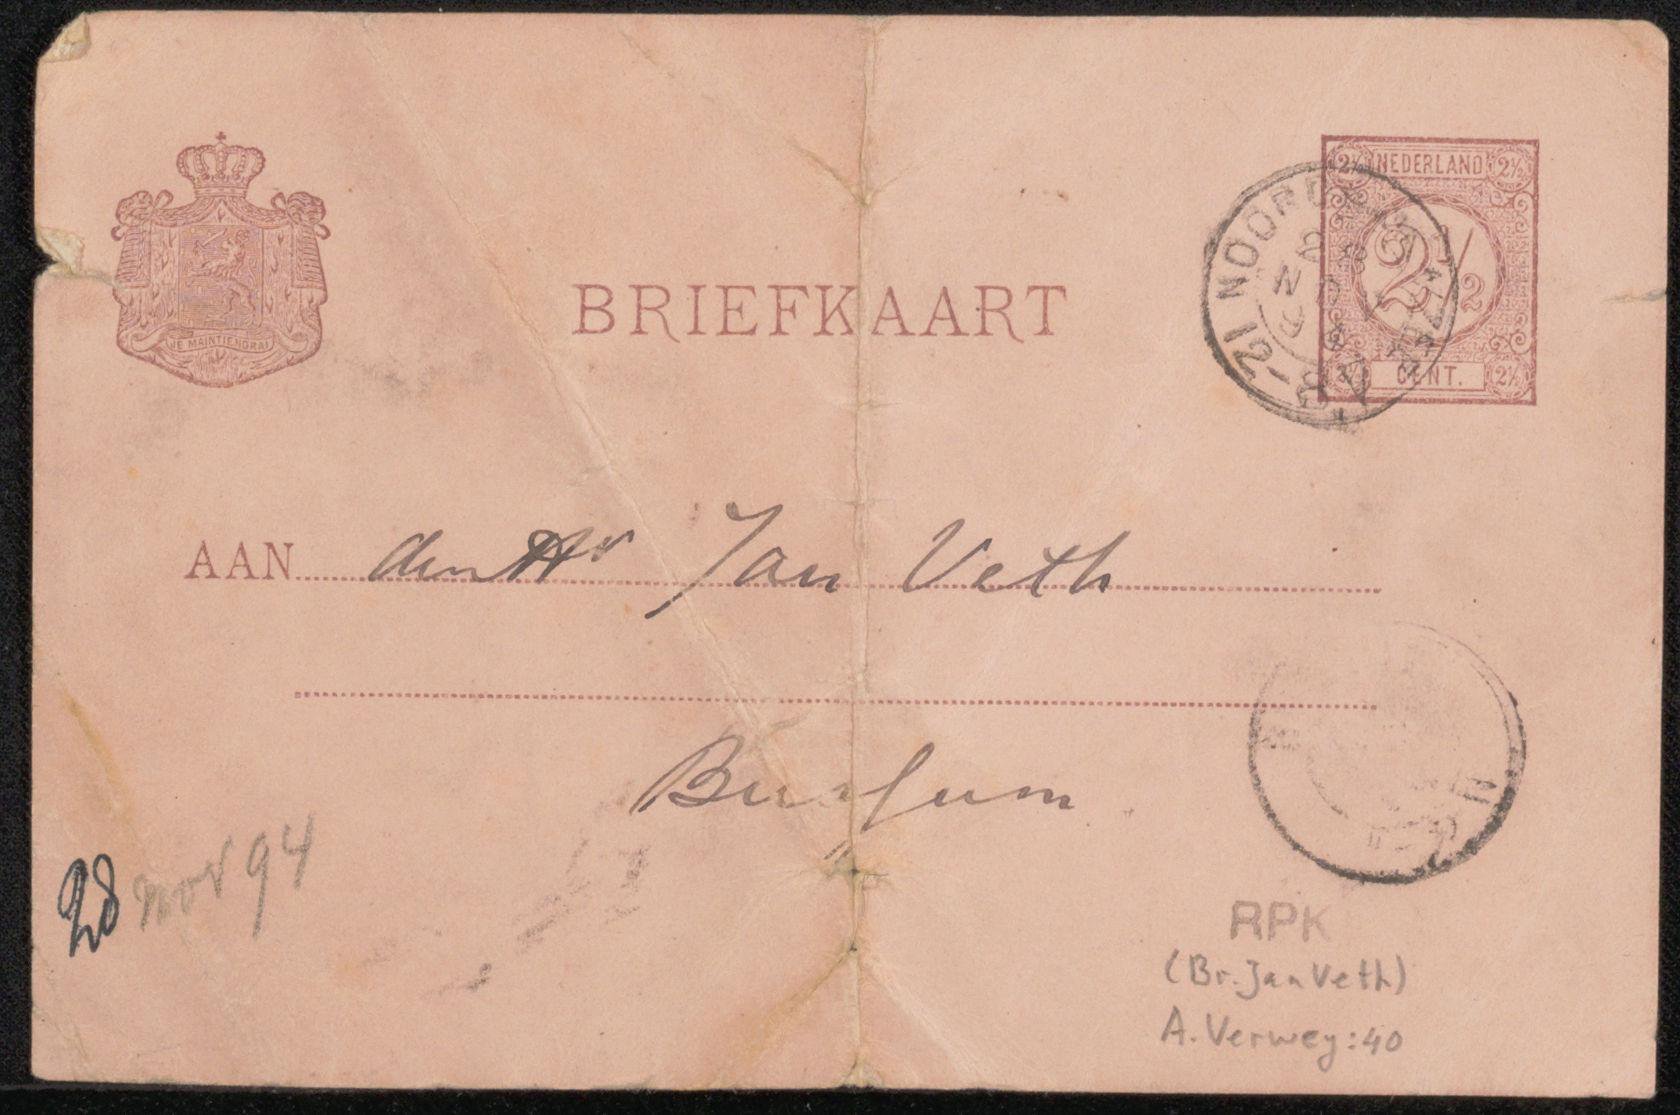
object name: postcard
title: Briefkaart aan Jan Veth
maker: albert verwey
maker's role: criticus, dichter, essayist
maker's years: 1865-1937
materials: cardboard, ink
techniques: pen, writing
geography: noordwijk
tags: dordrecht, painter, jan veth, frits lapidoth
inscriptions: collector's mark: ‘RPK’